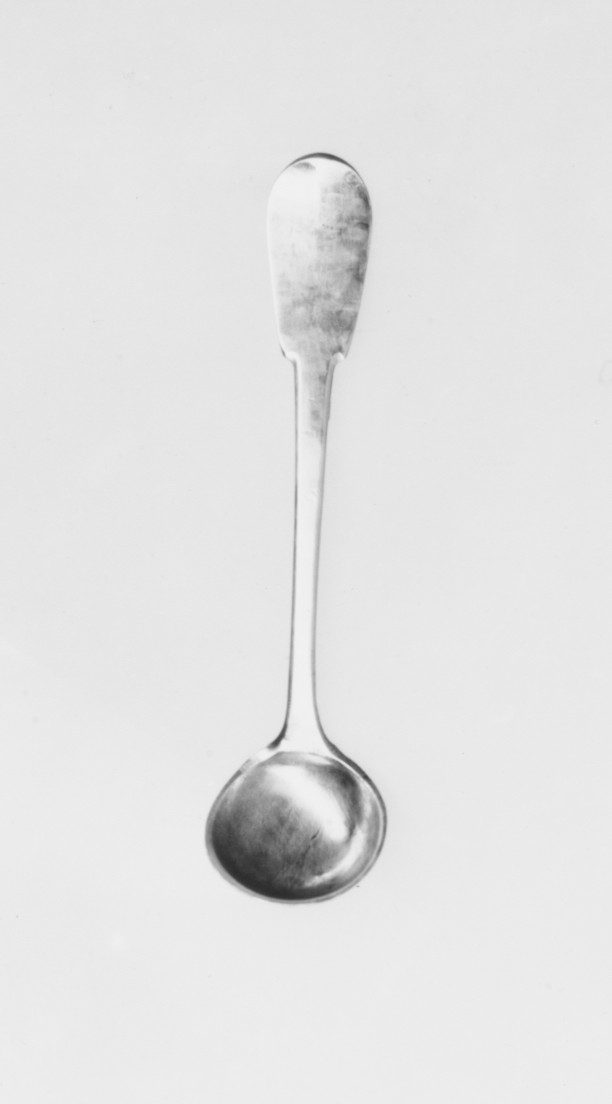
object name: mustard spoon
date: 1781-1792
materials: silver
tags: coat of arms